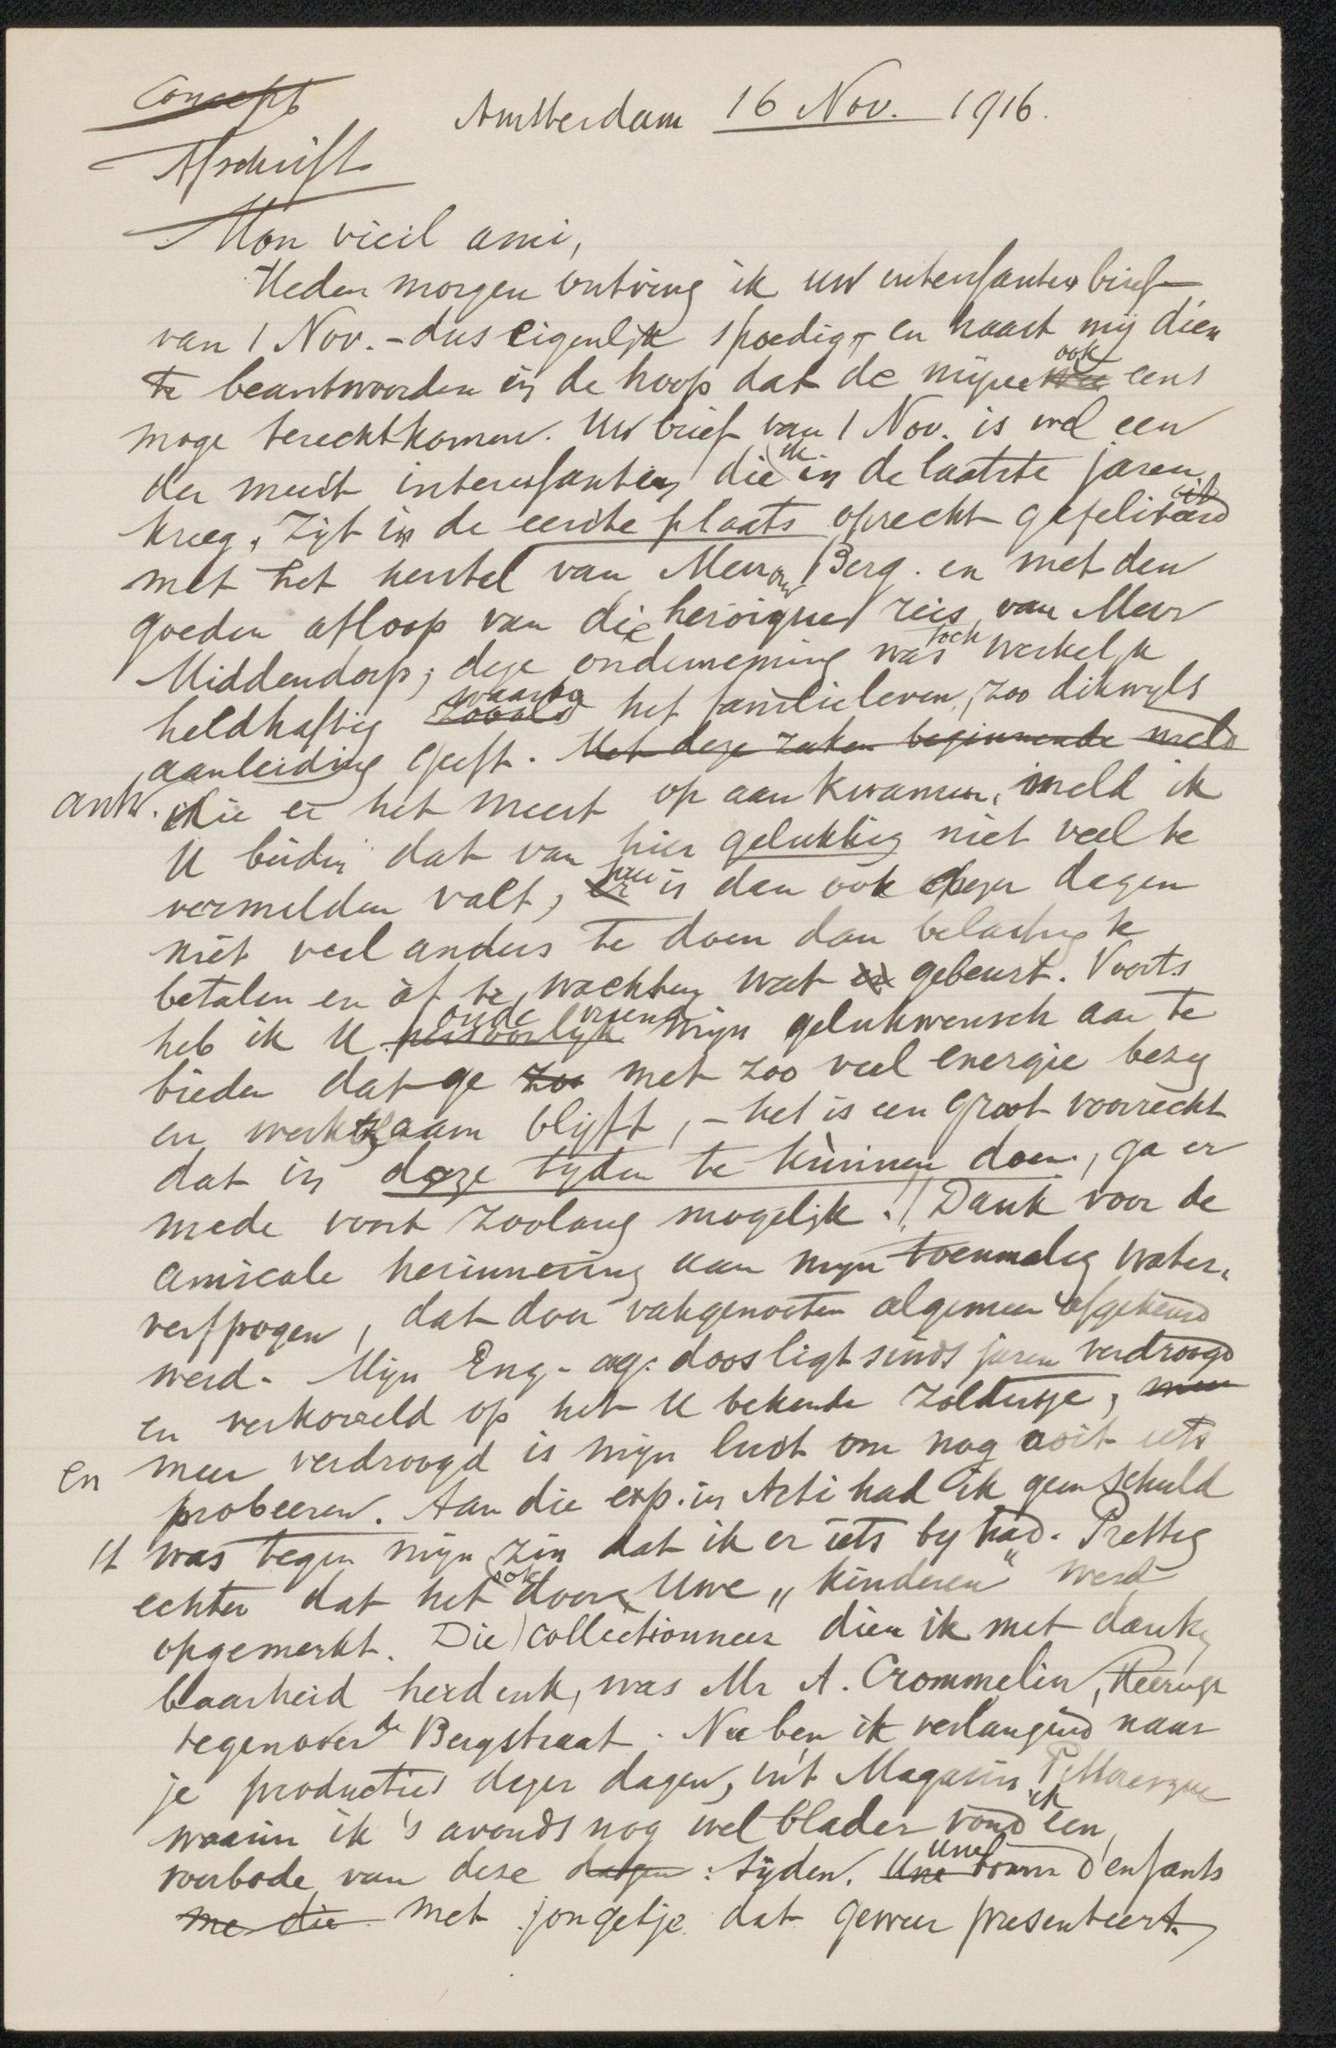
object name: letter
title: Brief aan anoniem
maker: august allebé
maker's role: draughtsman, print maker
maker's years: 1838-1927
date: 1916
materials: ink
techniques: pen, writing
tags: drawing, the graphic arts, painting (including book-illumination, miniature-painting), exhibition ~ art